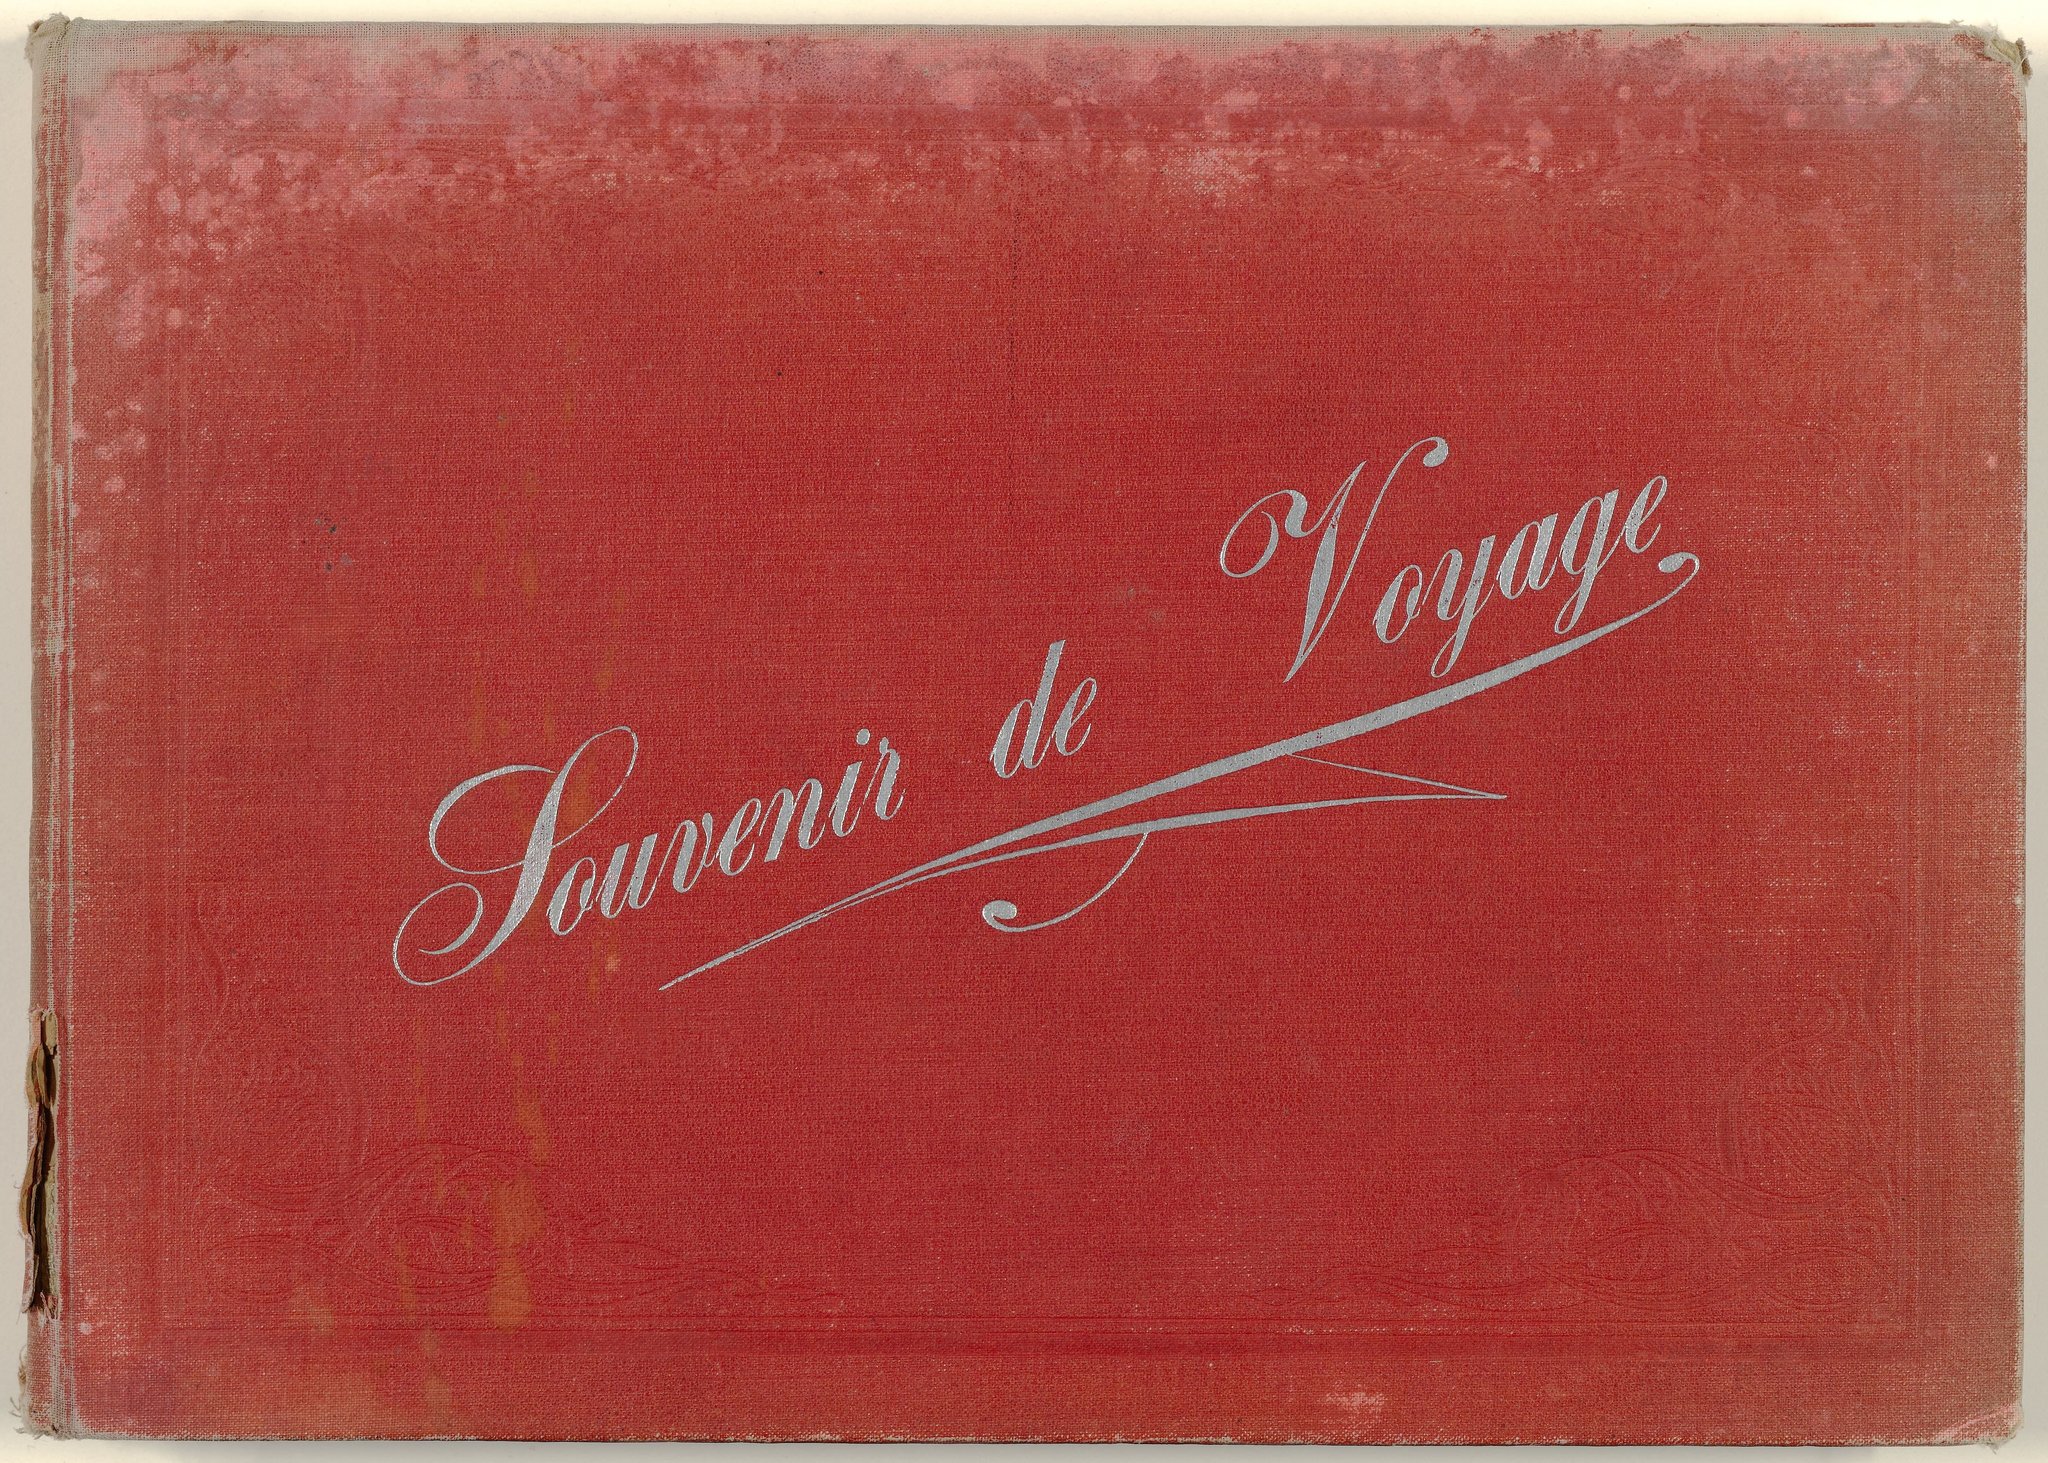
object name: photograph album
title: Fotoalbum van Suriname 1903 - 1910. 'Souvenir de Voyage', deel 3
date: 1903-1910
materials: cardboard, photographic support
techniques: cyanotype, gelatin silver print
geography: suriname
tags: suriname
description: Fotoalbum met harde kaft bekleed met rood linnen met op de voorkant in sierlijke letters gedrukt in reliëf in zilver: Souvenir de Voyage. Op de verbleekte rug het deelnummer 3. Onderdeel van een groep van vijf gelijknamige albums nummerd 1-5. Het album bevat 24 bladen van karton met 171 foto's geplakt op beide bladzijden en op de schutbladen van het album. Sommige foto's zijn genummerd en hebben een handgeschreven bijschrift. Van veel opnames zijn de ingeplakte afdrukken in tweevoud aanwezig, in zwart-wit en in blauw (cyanotypie) op de tegenover liggende bladzijde. Leven van de familie Doijer (Hendrik Doijer en Henriette Maria Catharina Kranenburg) in en rond de plantage Ma Retraite in Suriname in de jaren 1903-1910.